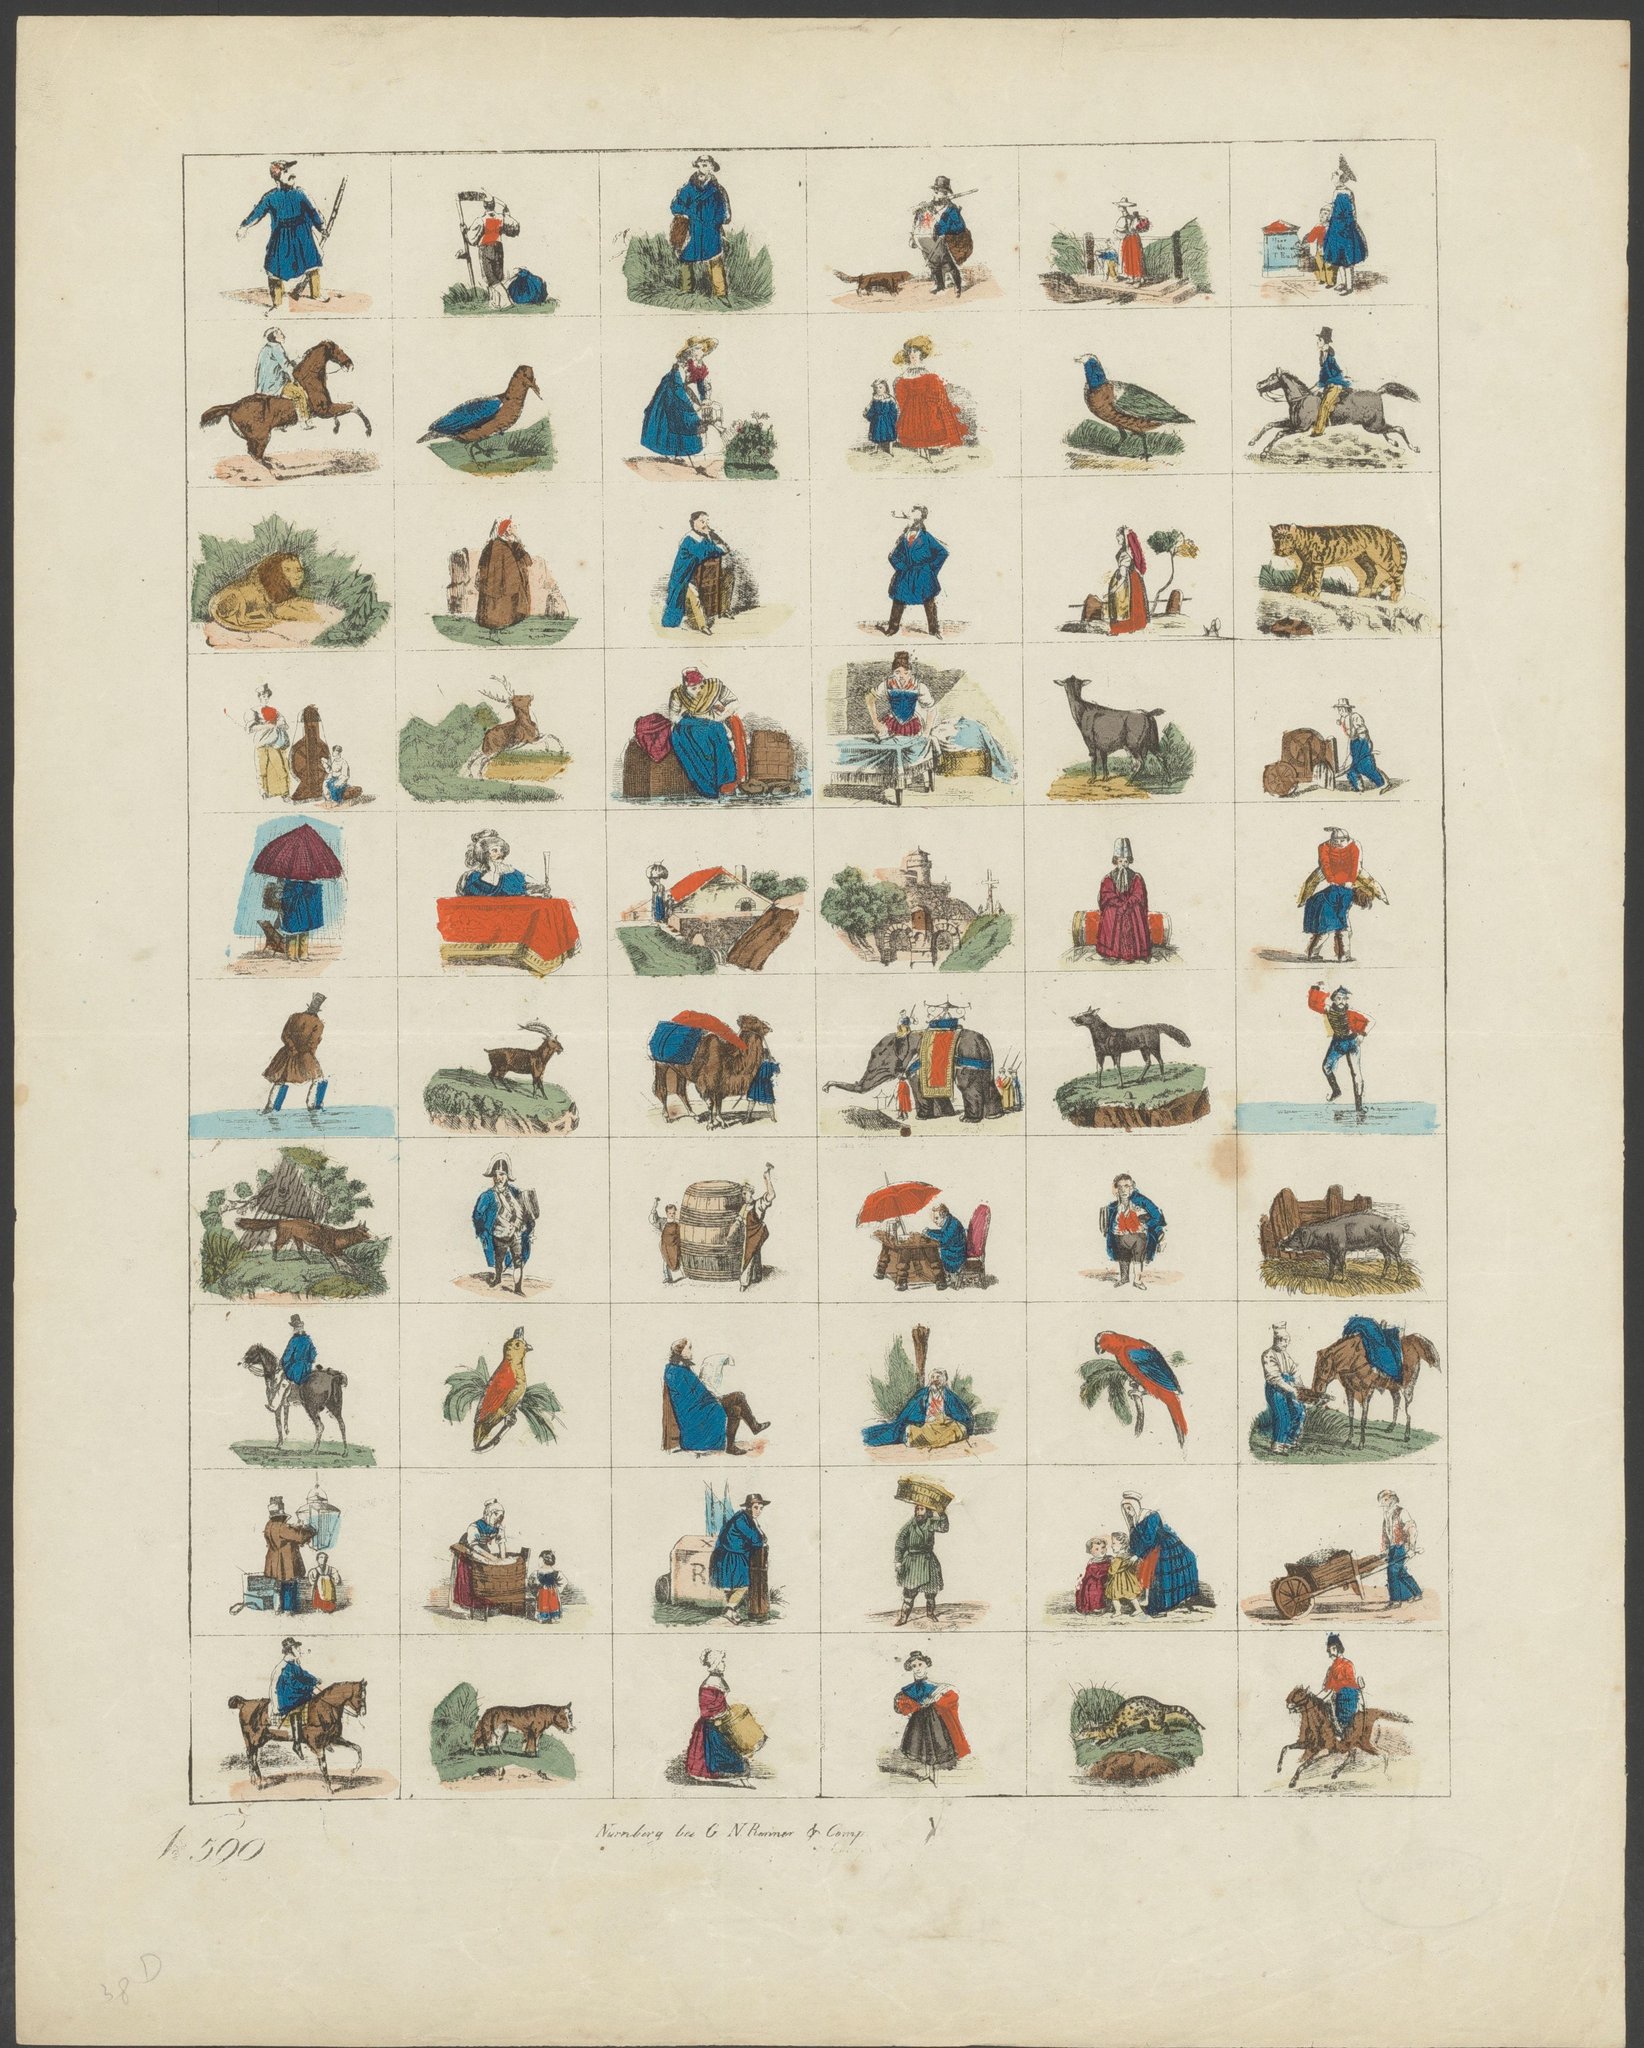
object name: popular print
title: Figuren en dieren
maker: Anonymous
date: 1837-1868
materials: paper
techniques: hand coloring, lithograph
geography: nuremberg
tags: animals, human types; peoples and nationalities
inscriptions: collector's mark: Lugt 1641, stamp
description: Linksonder genummerd: No. 590. Onderwerpsrubrieken binnen de Atlas Zeden en Gewoonten: Zeden en Gewoonten in Engeren Zin, Des menschen beging, midden en einde, Kinderleven – Kinderspel en Kinderprenten.